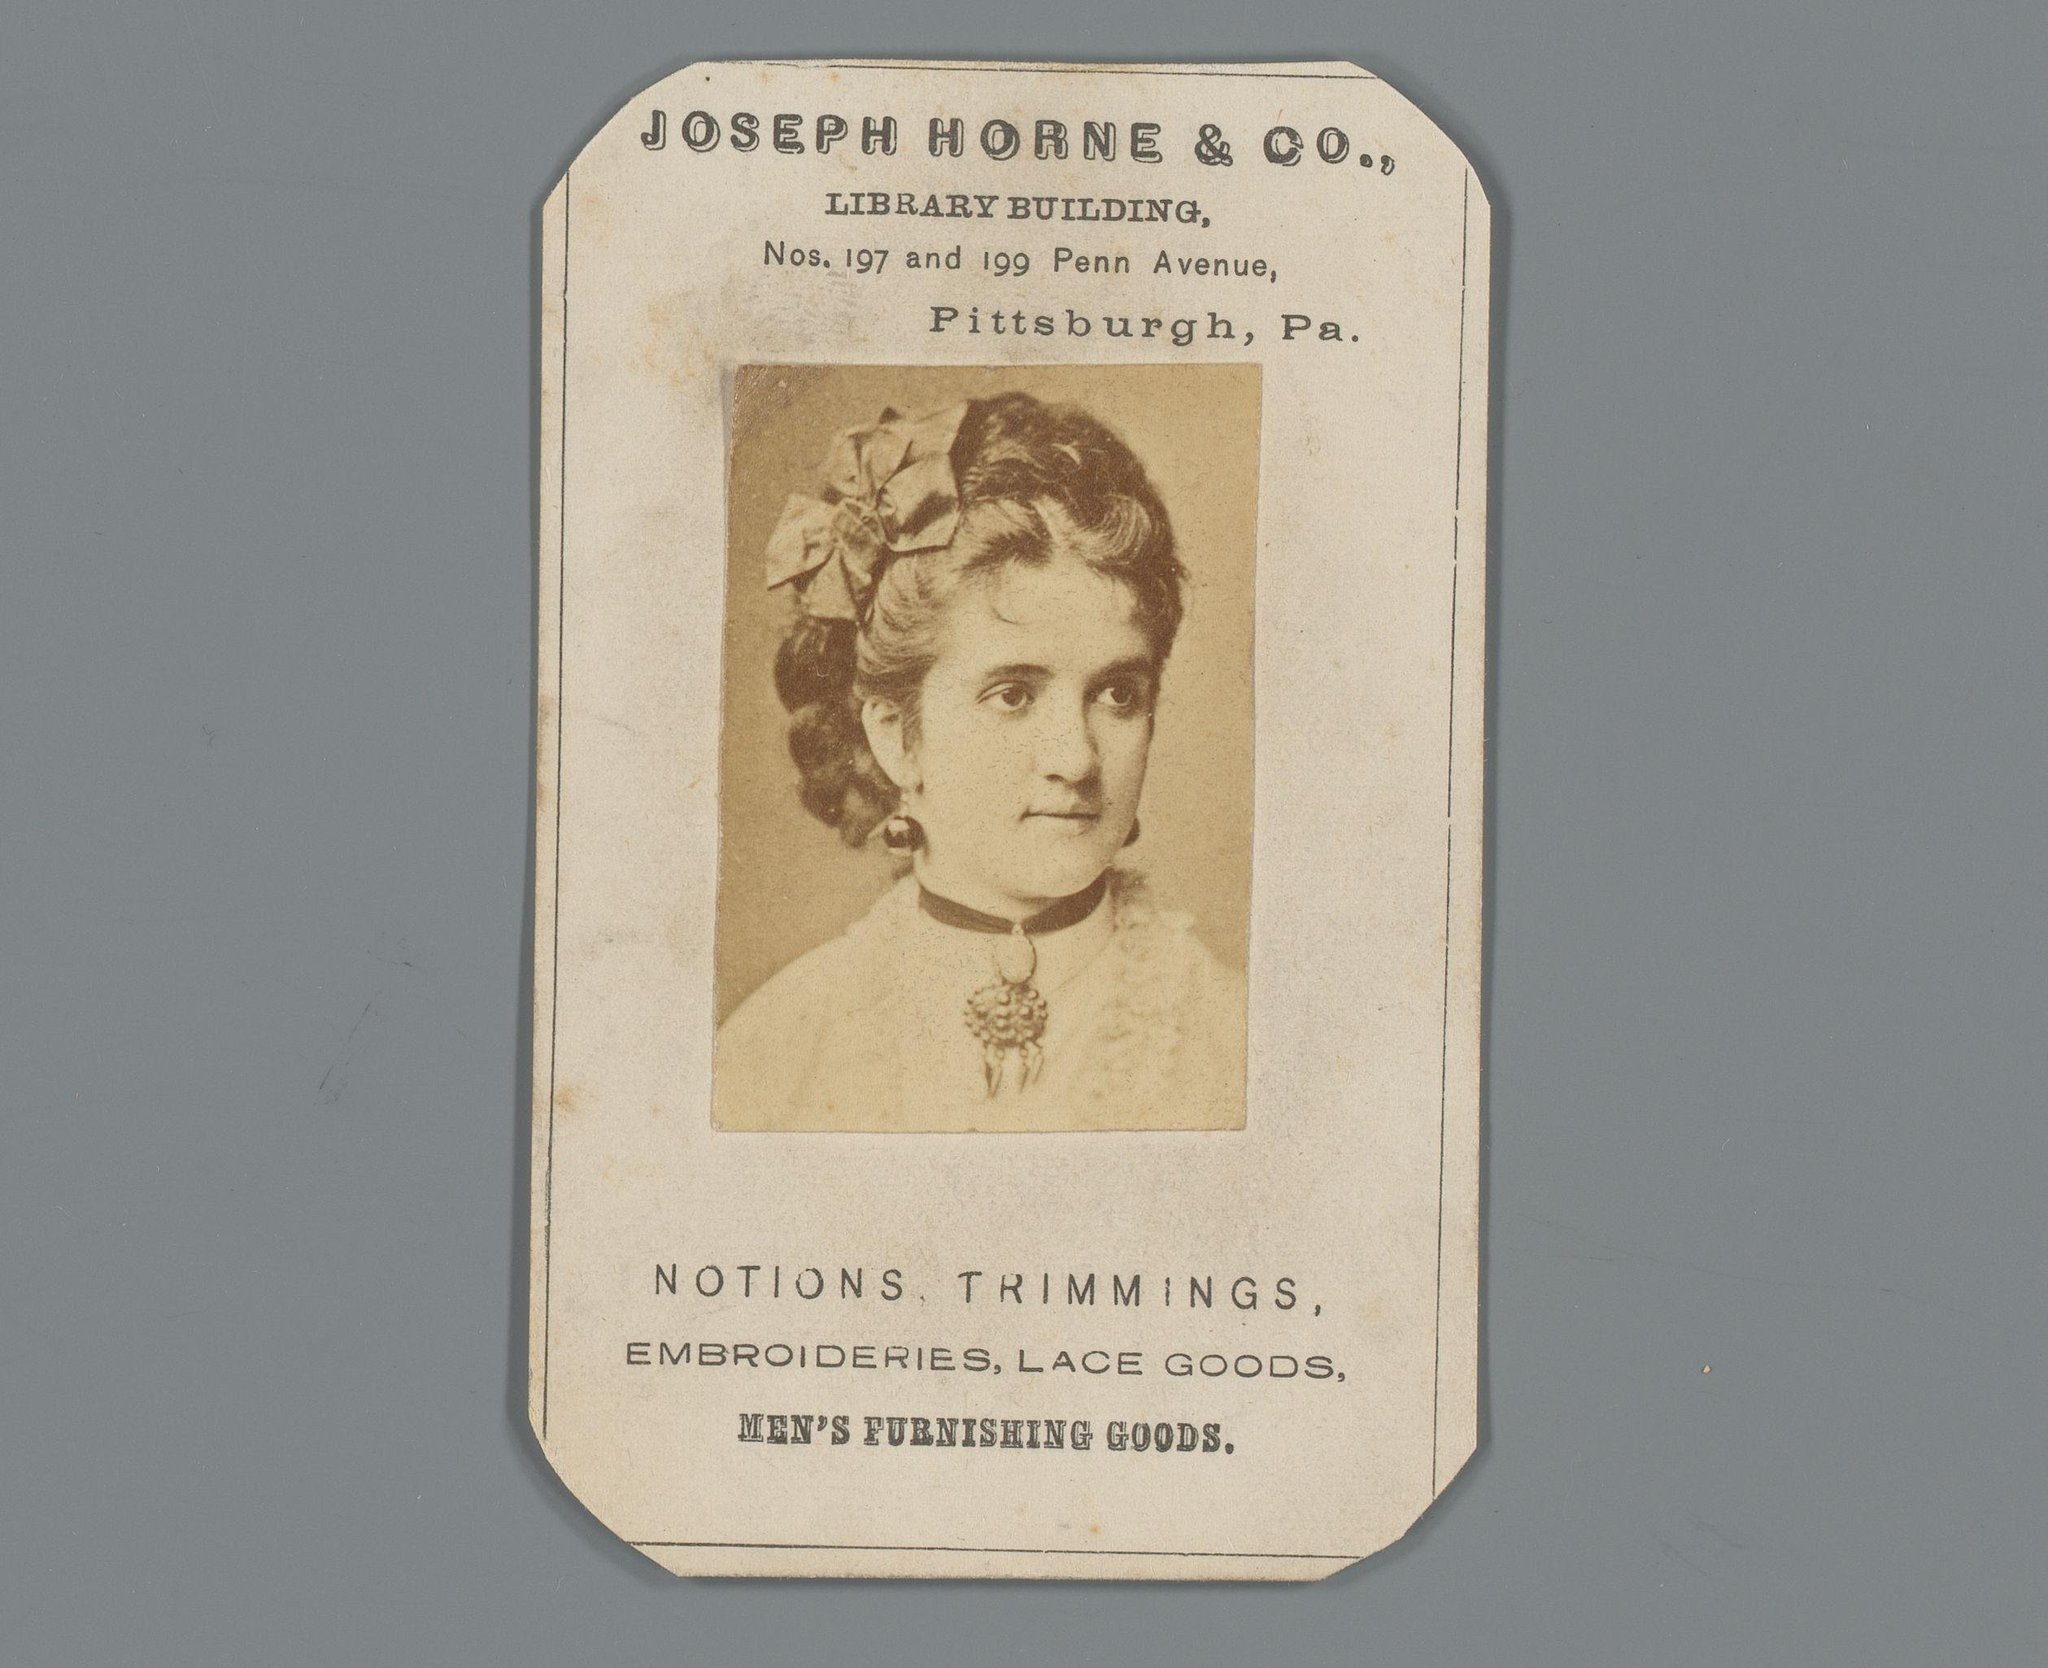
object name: photograph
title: Portret van een onbekende vrouw als reclame voor warenhuis Joseph Horne & Compay in Pittsburgh, Pennsylvania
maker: Anonymous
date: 1850-1915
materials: cardboard, photographic support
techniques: albumen print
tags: advertising, historical persons not known by name - bb - woman, textile industry and clothing industry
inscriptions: inscription: ‘JOSEPH HORNE & CO.,/ LIBRARY BUILDING,/ Nos. 197 and 199 Penn Avenue/ Pittsburgh, Pa./ NOTIONS, TRIMMINGS, EMBROIDEIES, LACE GOODS./ MEN'S FURNISHING GOODS.’